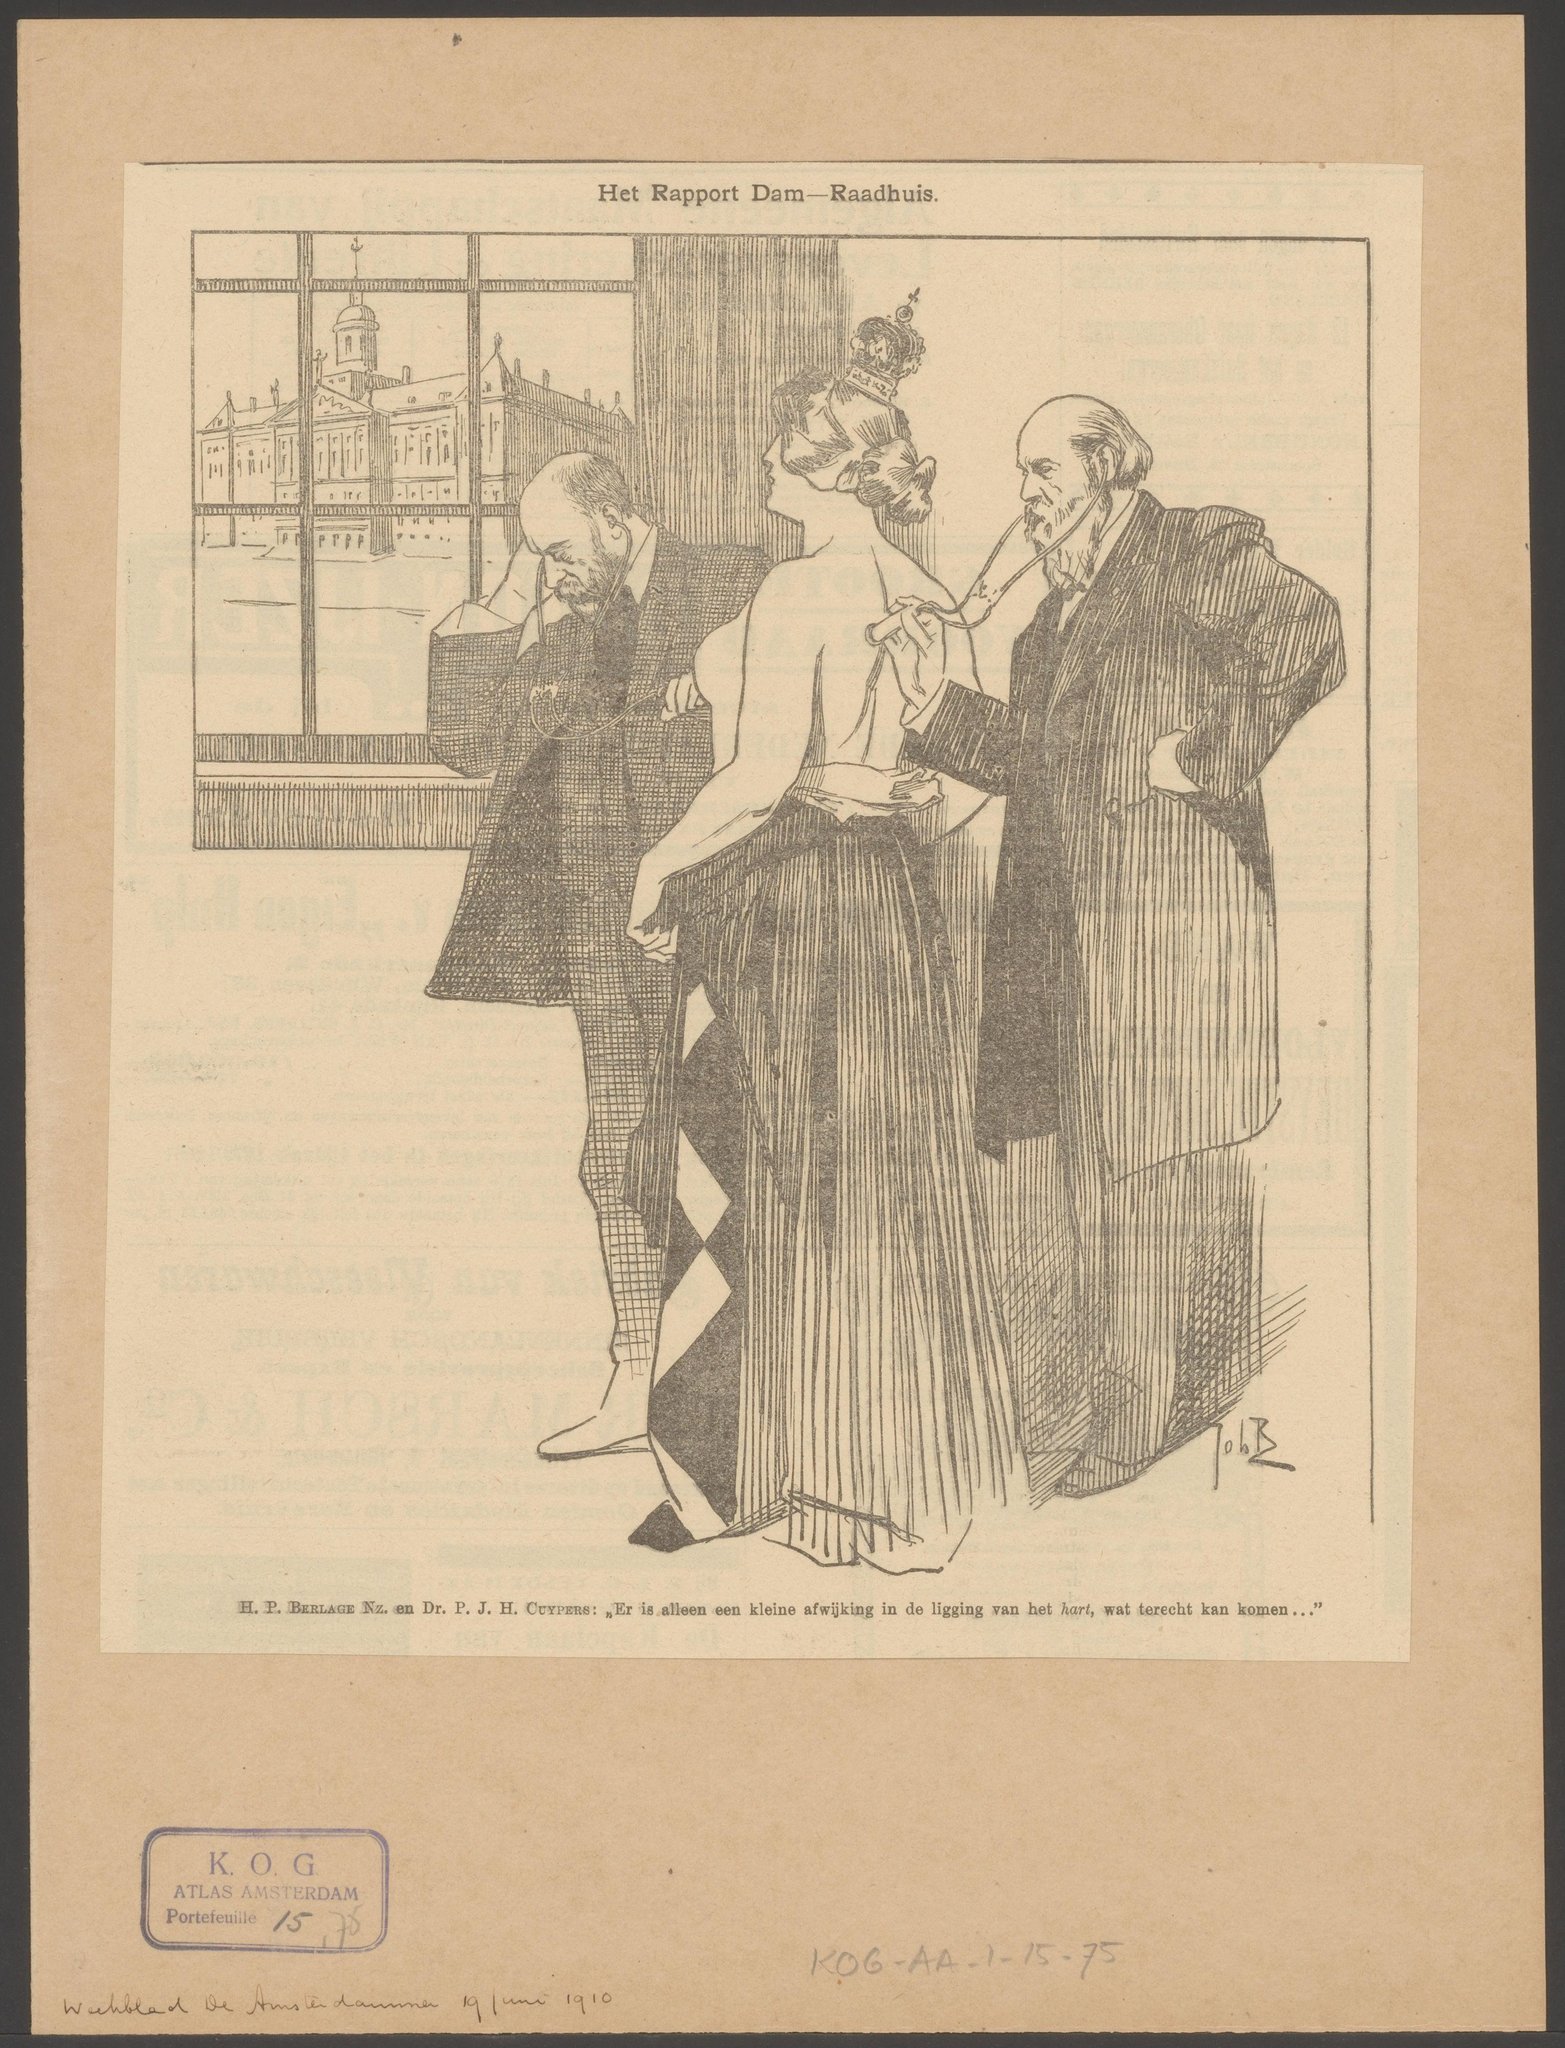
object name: cartoon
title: Spotprent over de Paleis-Raadhuiskwestie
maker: johan braakensiek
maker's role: draughtsman, print maker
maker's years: 1858-1940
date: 1910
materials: paper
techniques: letterpress printing, linocut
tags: crown (symbol of sovereignty), city-view in general; 'veduta', palace, royal palace of amsterdam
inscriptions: collector's mark: ‘15,75’ Lugt 1641b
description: Onderwerpsrubriek binnen de Atlas Amsterdam: Nieuwe Stadhuis op de Dam, van buiten, Kleine steentjes kwestie, Paleis - Raadhuiskwestie.